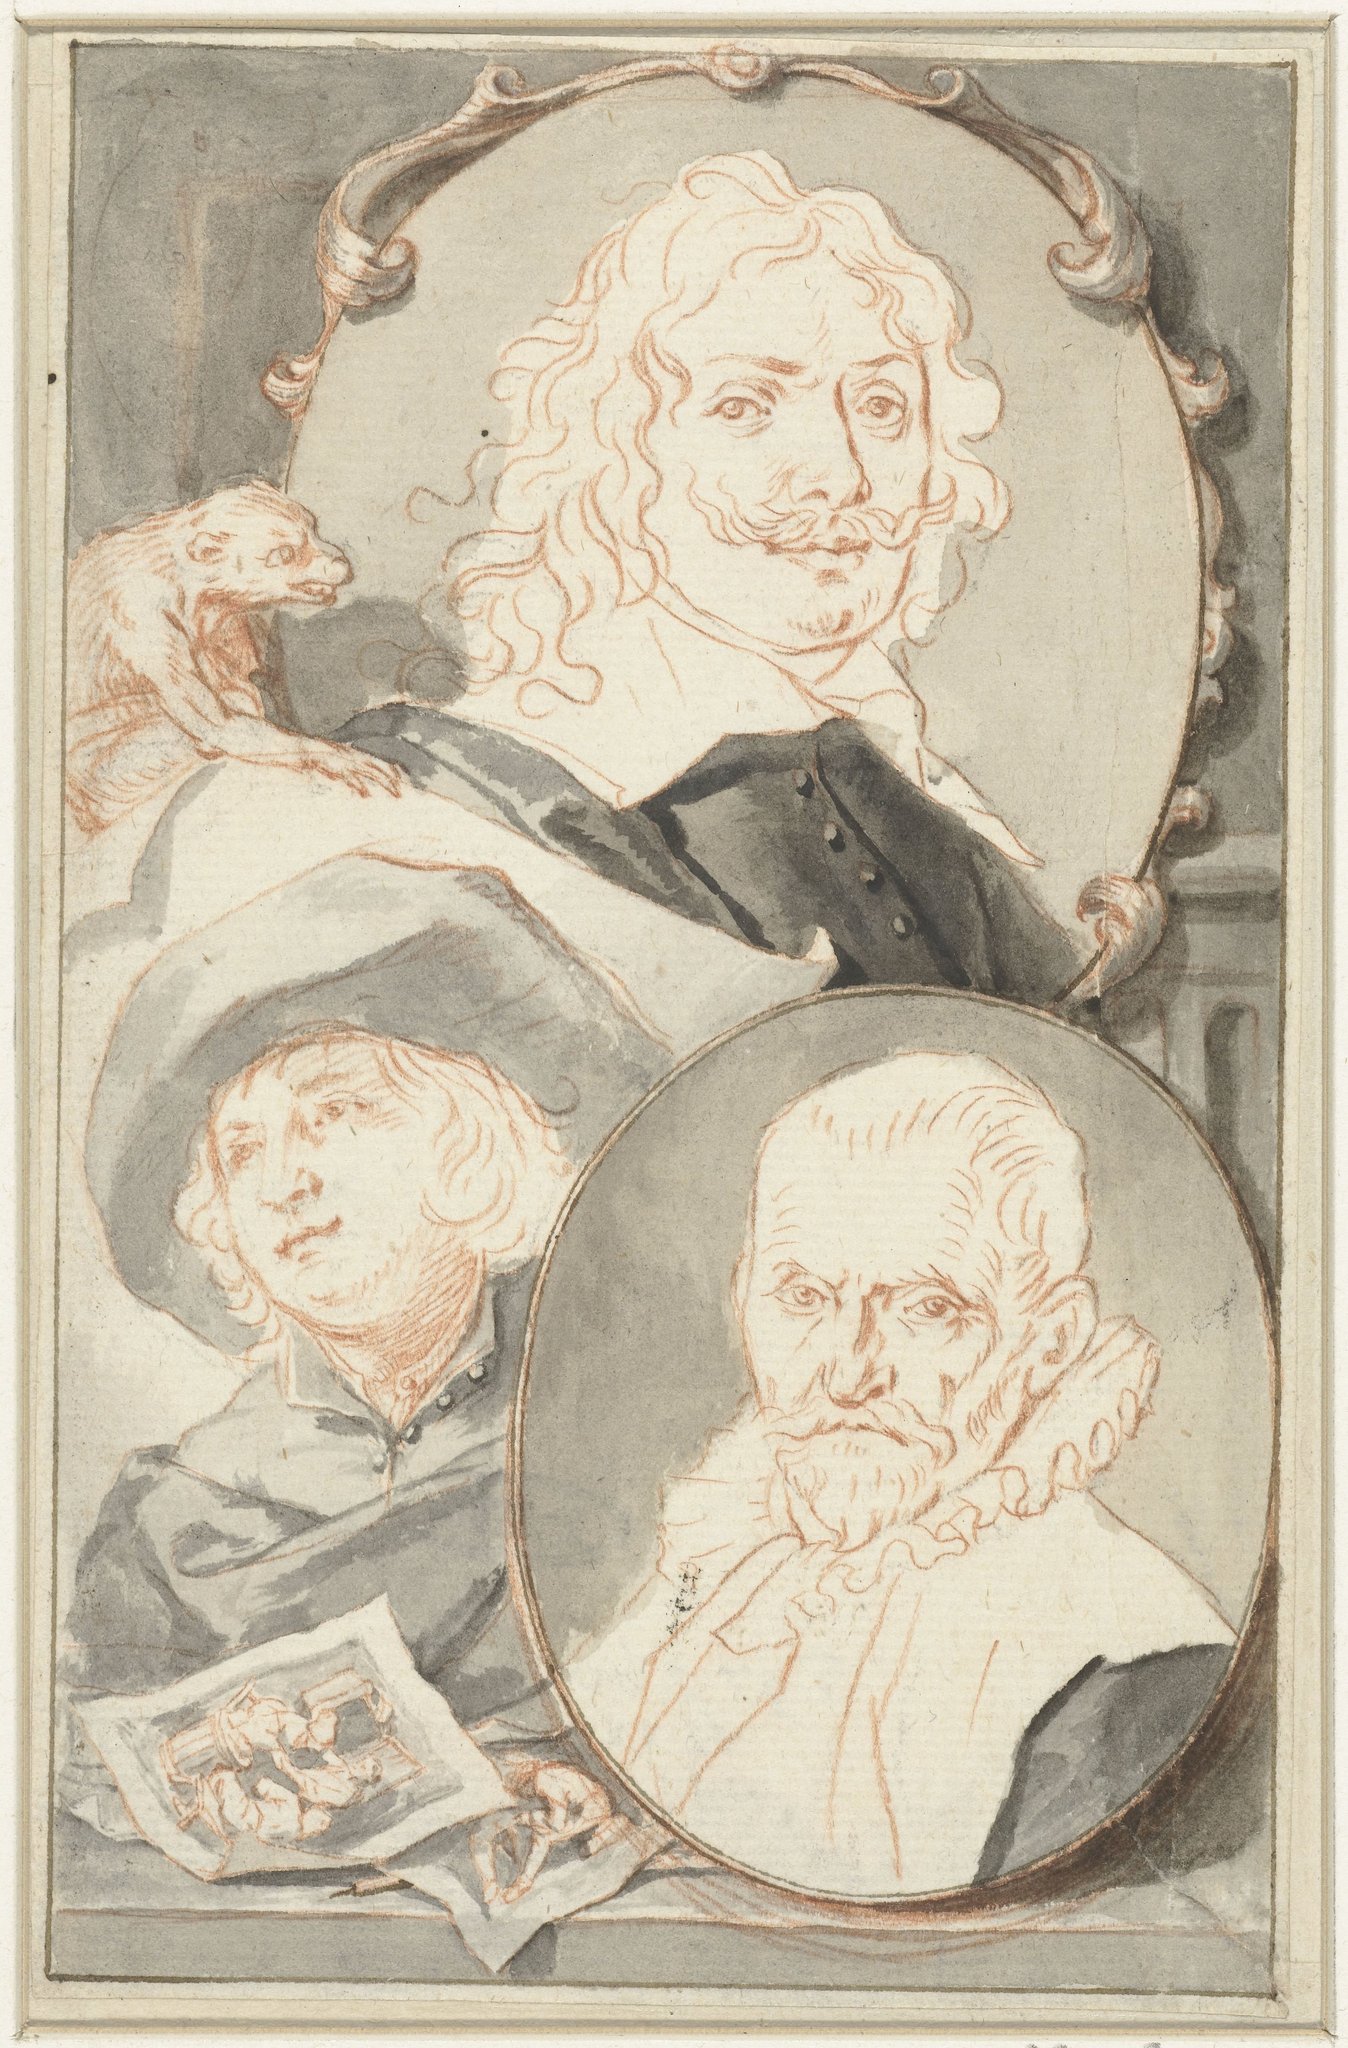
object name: design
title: Portretten van Adriaan Brouwer, Jurriaen Ovens en Cornelis Bega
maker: jacob houbraken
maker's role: draughtsman, print maker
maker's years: 1698-1780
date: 1708-1780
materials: chalk, ink, paper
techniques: brush, pen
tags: jürgen ovens, antwerp, painter, adriaen brouwer, cornelis pietersz. bega, historical persons, portrait, self-portrait of painter, portrait, self-portrait of artist